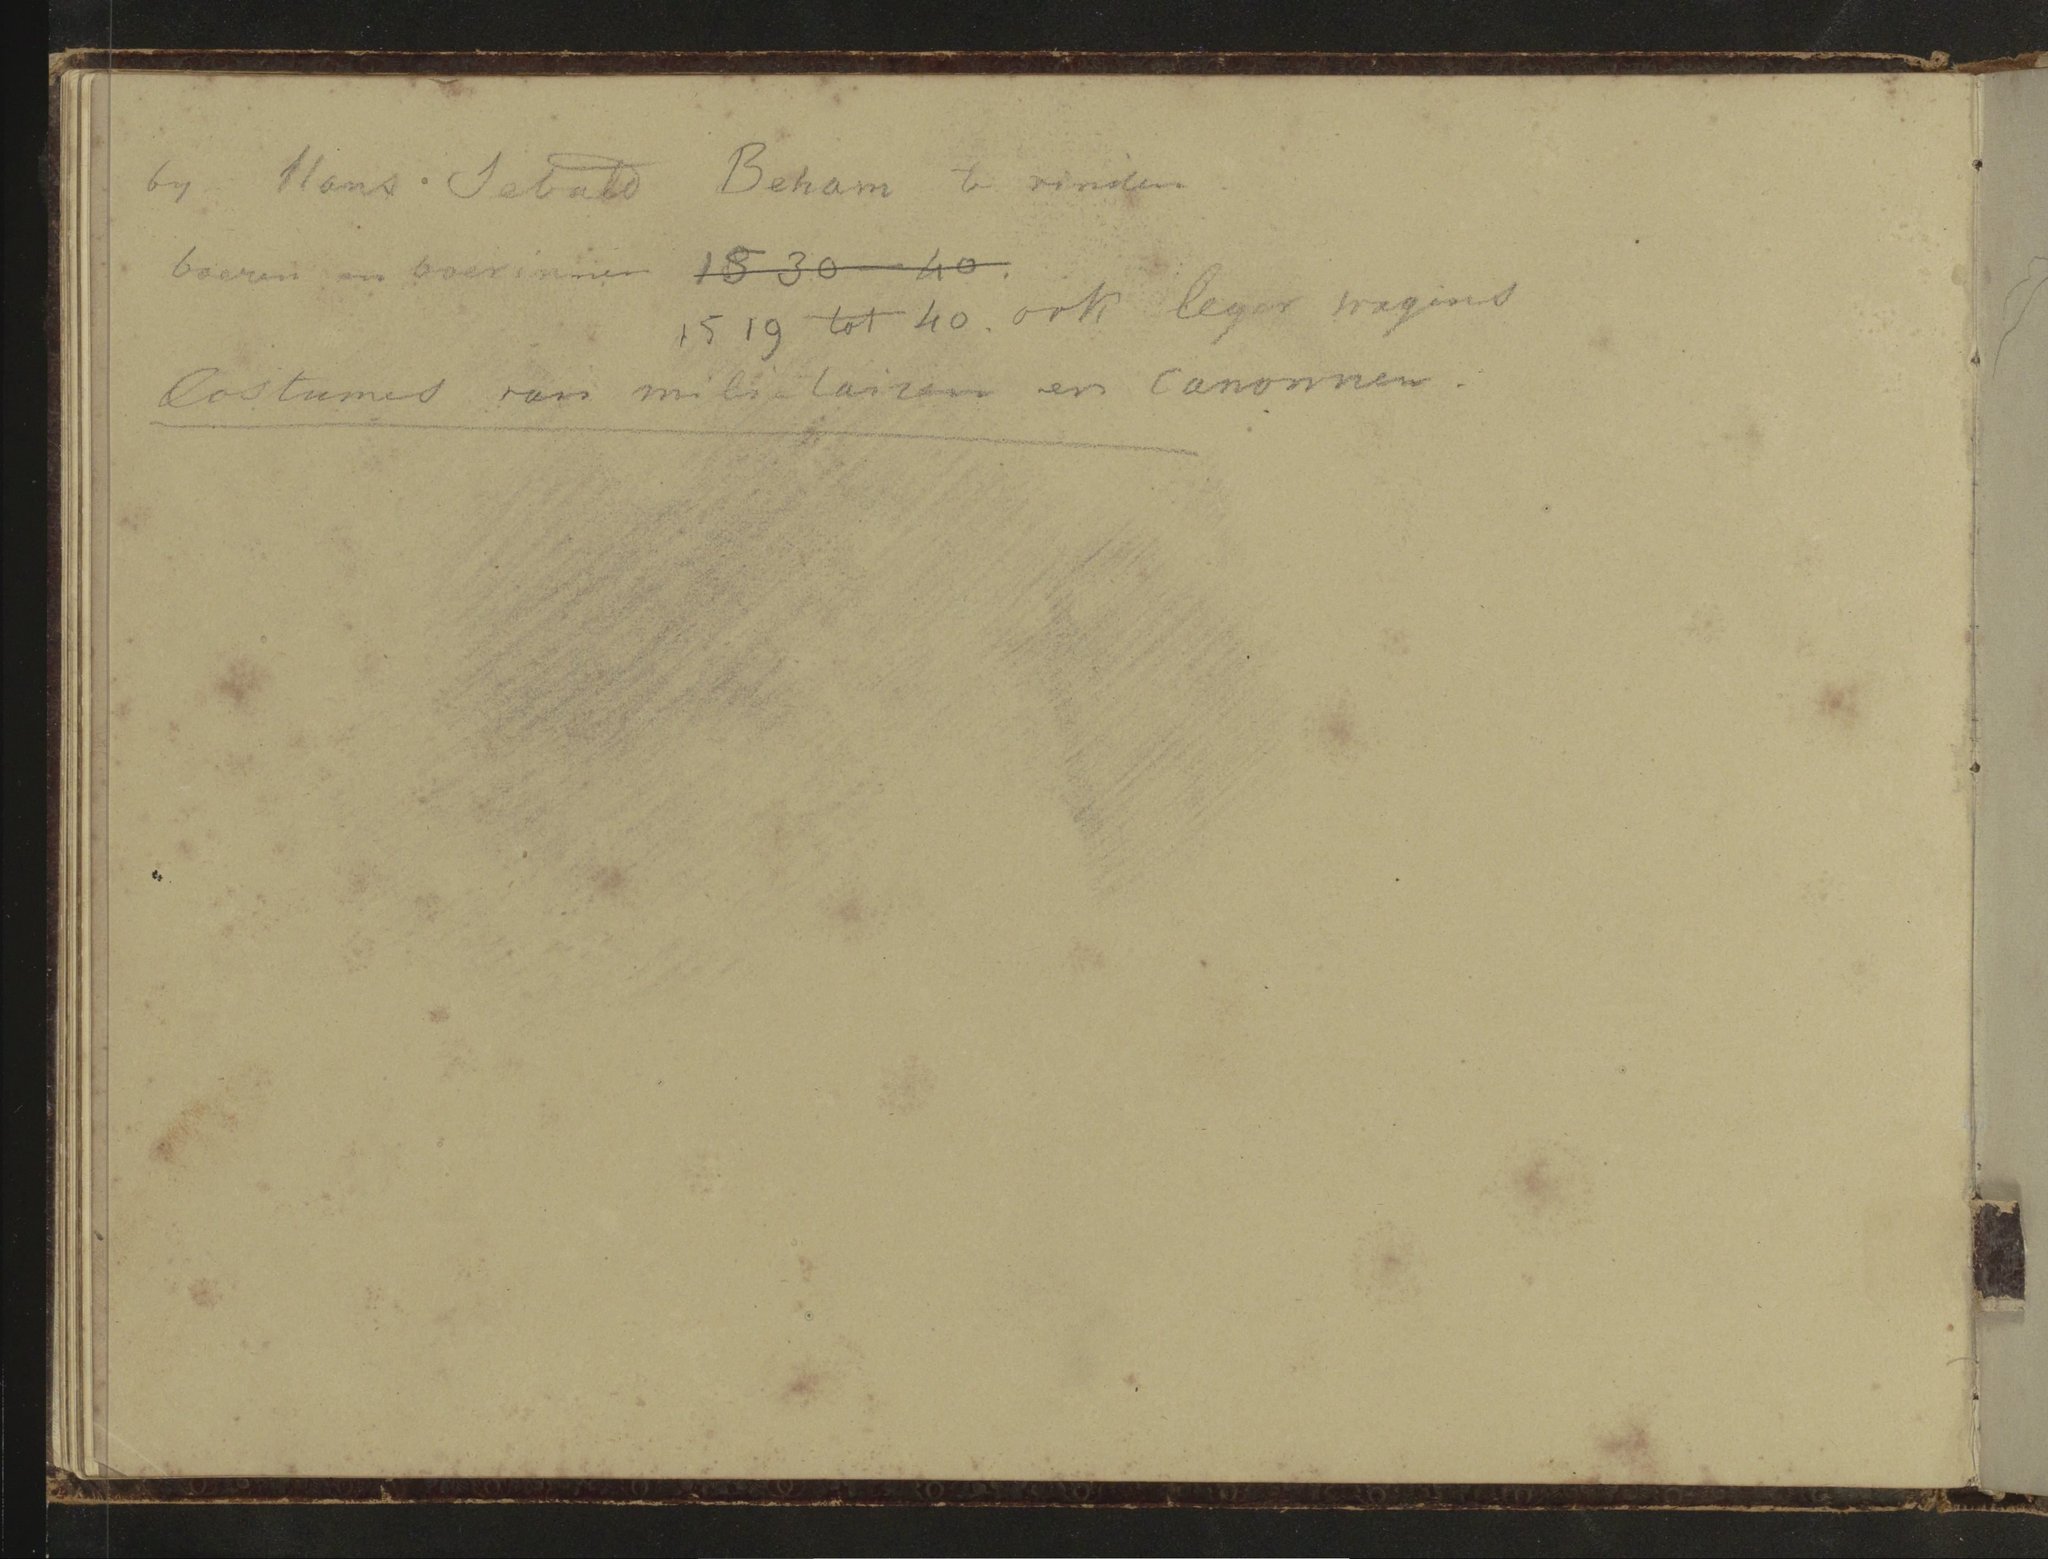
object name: sketchbook leaf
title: Notities over de prentmaker Hans Sebald Beham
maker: reinier craeyvanger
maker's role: draughtsman, print maker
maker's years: 1812-1880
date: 1822-1880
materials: paper, pencil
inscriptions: annotation: ‘bij Hans Sebald Beham te vinden/ boeren en boerinnen 1530 40/ 1519 tot 40 ook leger wagens/ costumes van militairen en canonnen.’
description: Blad 25 verso uit een schetsboek met 45 bladen.